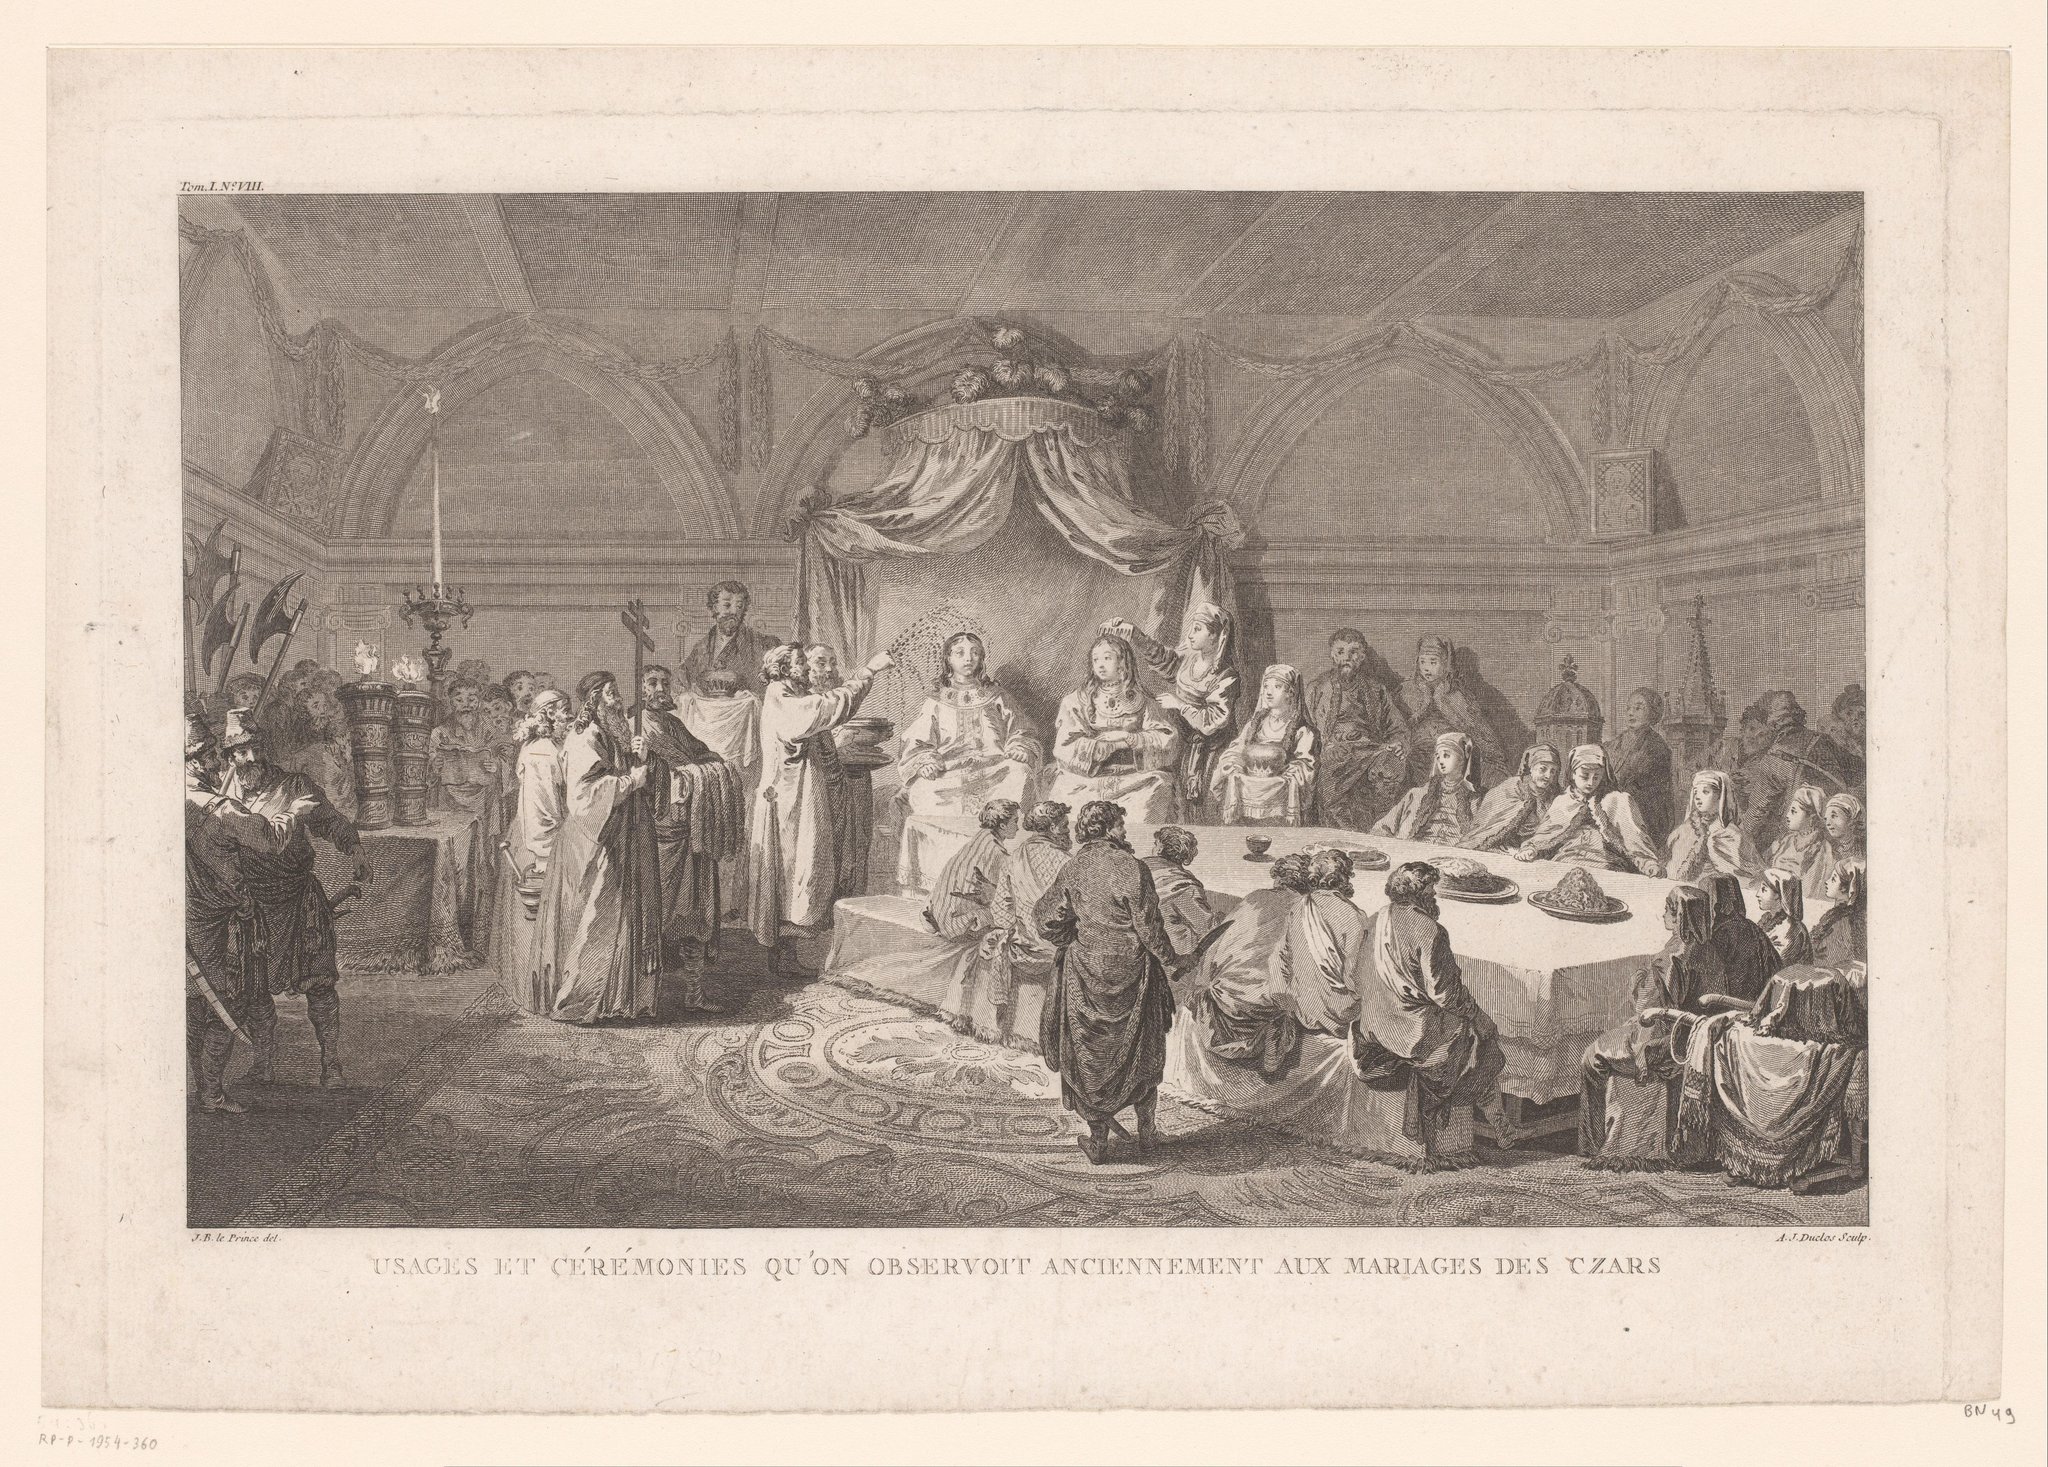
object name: print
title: Usages et cérémonies qu'on observoit anciennenemt aux mariages des Czar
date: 1768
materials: paper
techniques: etching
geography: france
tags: russian orthodox church, (civil) marriage ceremonies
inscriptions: collector's mark: Lugt 2228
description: Prent uit: d'Auteroche, Chappe. Voyage en Sibérie: Fait Par Ordre Du Roi en 1761. Parijs: De Bure I, 1768.